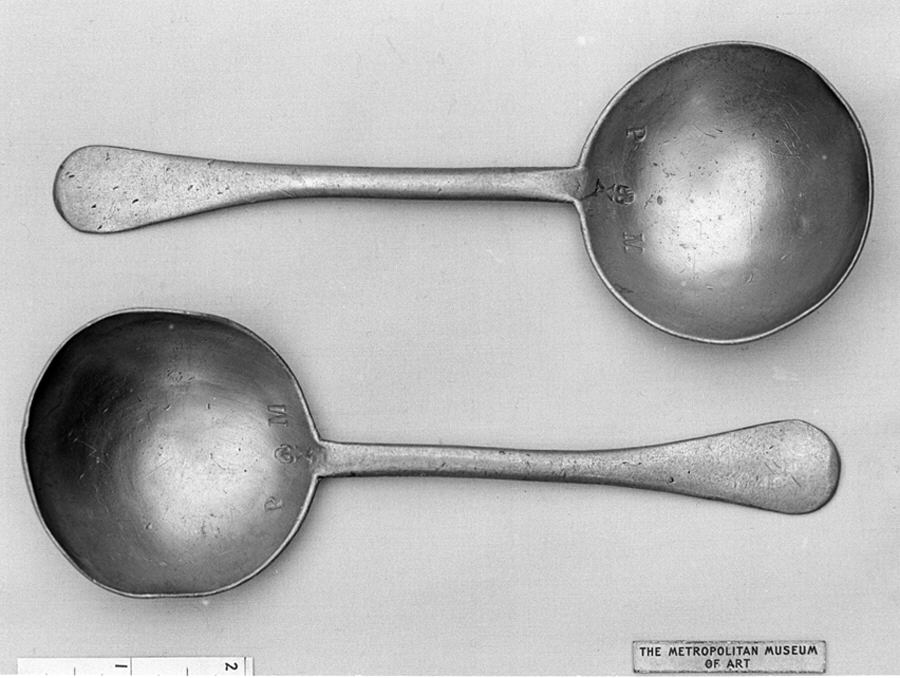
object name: spoon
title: Pair of spoons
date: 1701-1800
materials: pewter